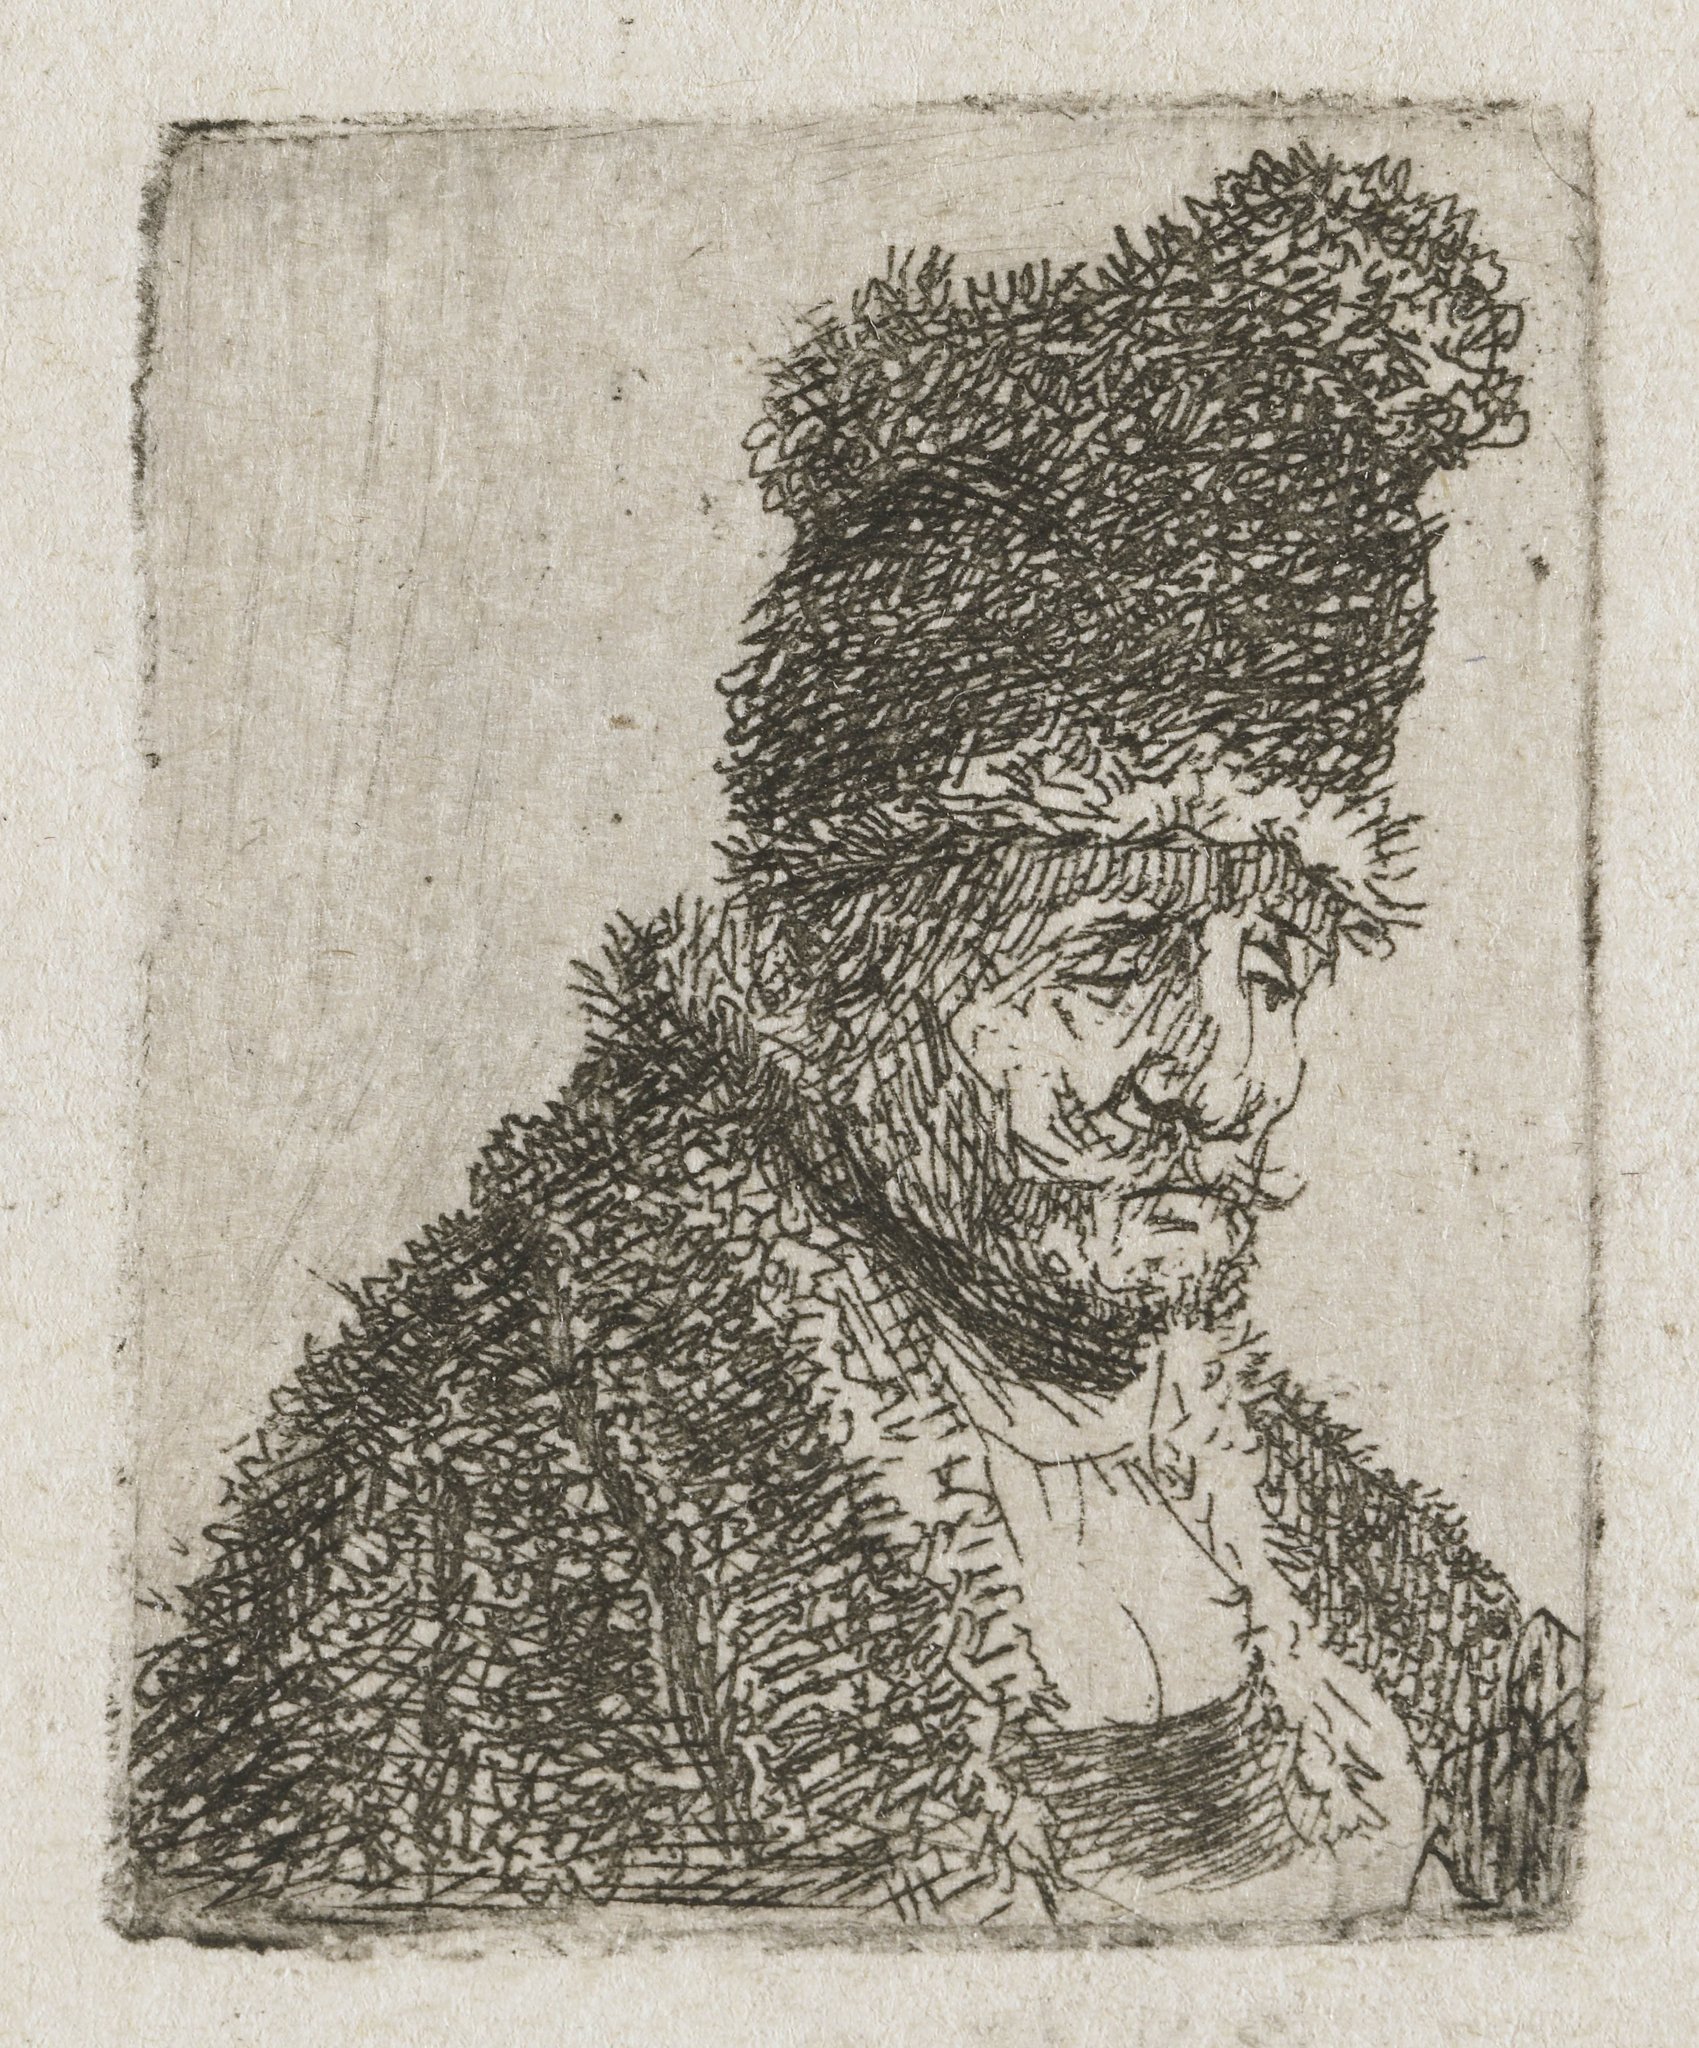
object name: print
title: Sheet of studies of men's head: old man in fur coat and high cap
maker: rembrandt van rijn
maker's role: draughtsman, painter, print maker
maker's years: 1606-1669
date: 1629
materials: paper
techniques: etching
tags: head-gear: cap (+ men's clothes)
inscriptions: collector's mark: Lugt 240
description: Another five small depictions of men’s heads, but this time it is certain that they did not originate as independent prints. Originally, they were all on the same copperplate. After Rembrandt cut up the plate, he completed each print individually. This working method was unusual and characterizes Rembrandt as an artist who often strayed off the beaten path.